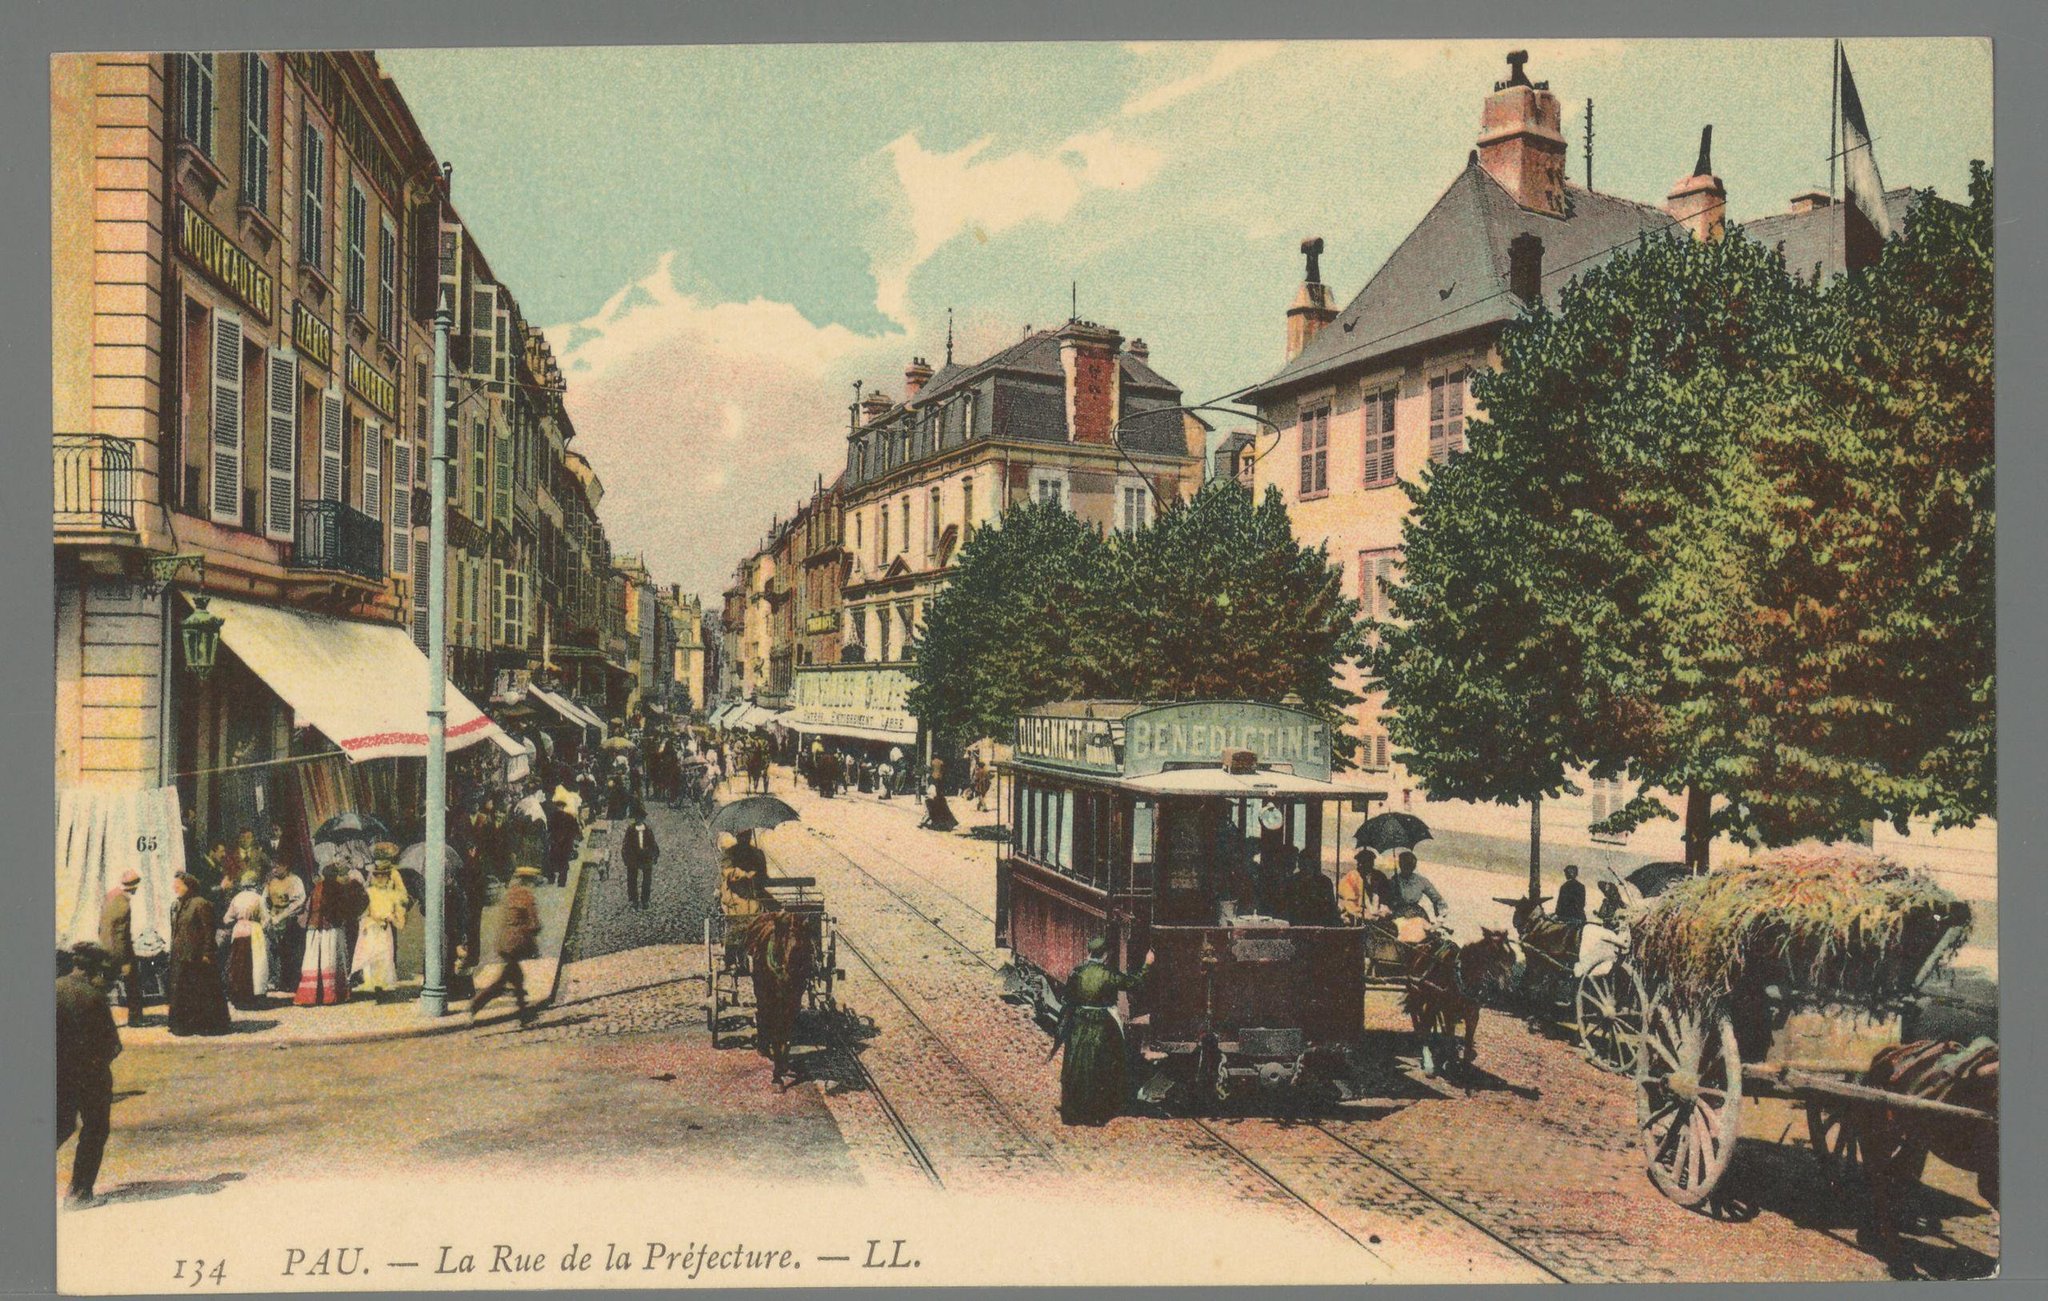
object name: photomechanical print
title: Pau. La Rue de la Préfecture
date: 1904-1906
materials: cardboard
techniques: photograph, lithograph, writing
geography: paris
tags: tram, street (+ city(-scape) with figures, staffage)